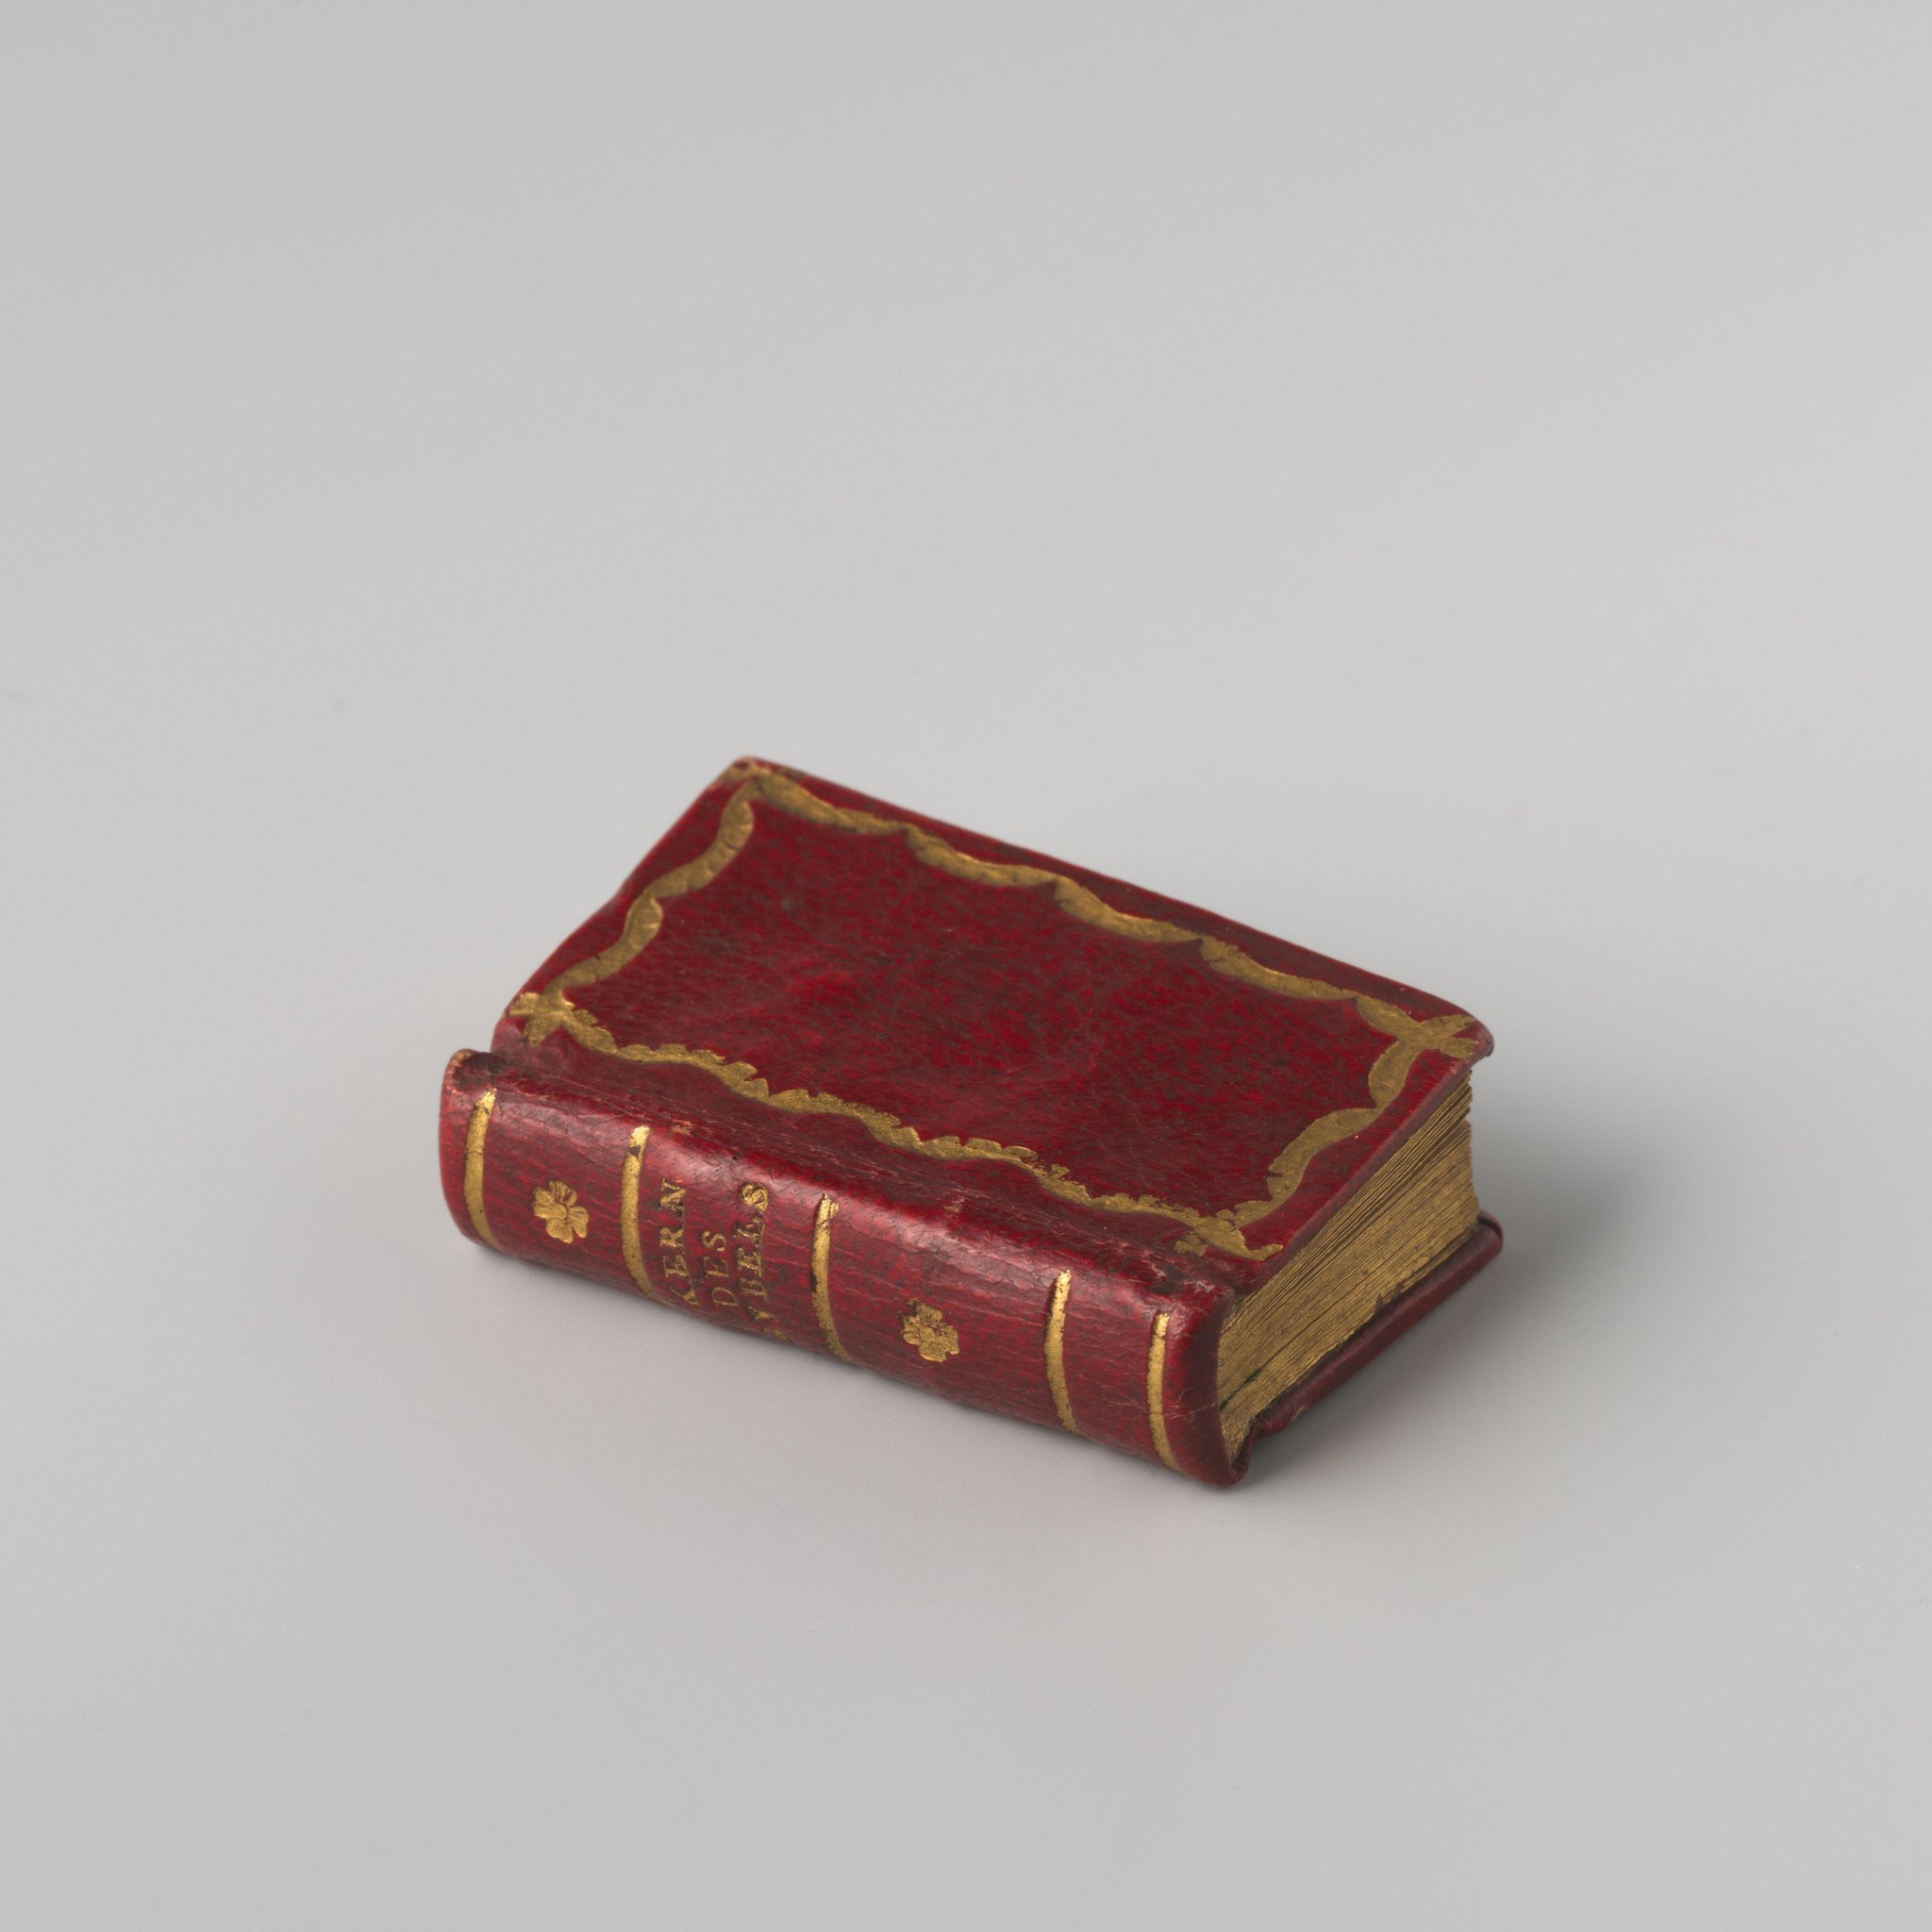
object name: book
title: Boek getiteld Kern des Bijbels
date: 1751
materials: leather, paper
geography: the hague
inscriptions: date